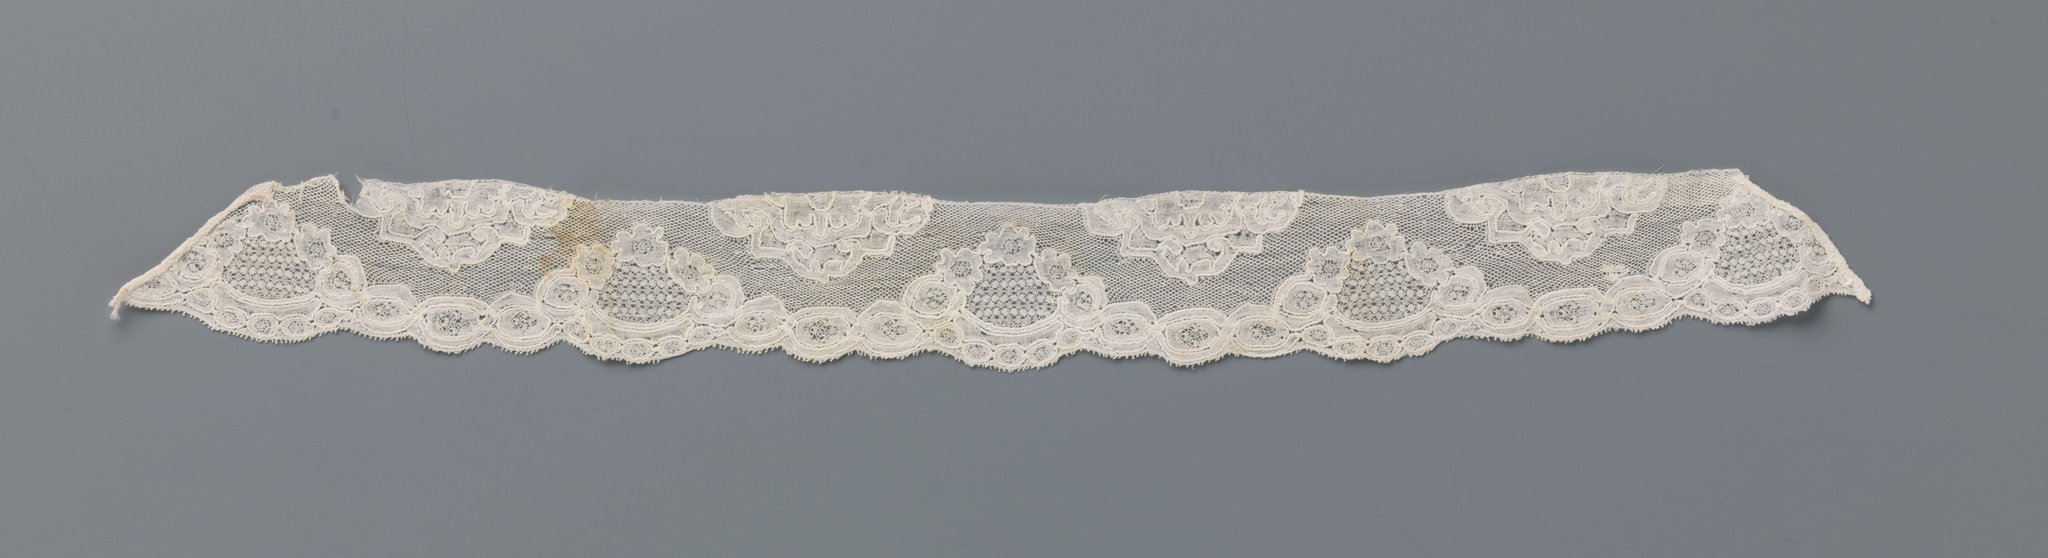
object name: strip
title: Strook kloskant met cartouches langs de onderrand afgewisseld door gehalveerde bloemen langs de bovenrand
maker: Anonymous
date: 1775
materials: linen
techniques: lace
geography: mechelen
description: Strook naturelkleurige kloskant: Mechelse kant. Het zich herhalende patroon bestaat uit een doorlopende en regelmatig golvende slinger, die cartouches vormt langs de onderzijde van de strook. De slinger bestaat uit ovalen, die langs de bovenkant van de cartouches overgaan in drie aaneengeschakelde bloemen en langs de onderkant van de cartouches bestaat uit een aaneenschakeling van vijf kleinere ovaaltjes. Een grote gehalveerde bloem hangt vanuit de bovenzijde van de strook naar beneden, steeds tussen de cartouches in en passend in het golfdal. De motieven zijn met elkaar verbonden door een fijne maasgrond, de Mechelse grond. De motieven zijn gemaakt in linnenslag en met dikkere en glimmende contourdraden. Enkele verschillende siergronden zijn toegepast in het centrum van de ovalen, in de bloemharten en een sneeuwvlokkengrond in de cartouches. De flauw geschulpte onderzijde is afgewerkt met picots. De bovenzijde is recht afgewerkt. De korte kanten zijn schuin weggeknipt en afgewerkt met een zoompje.